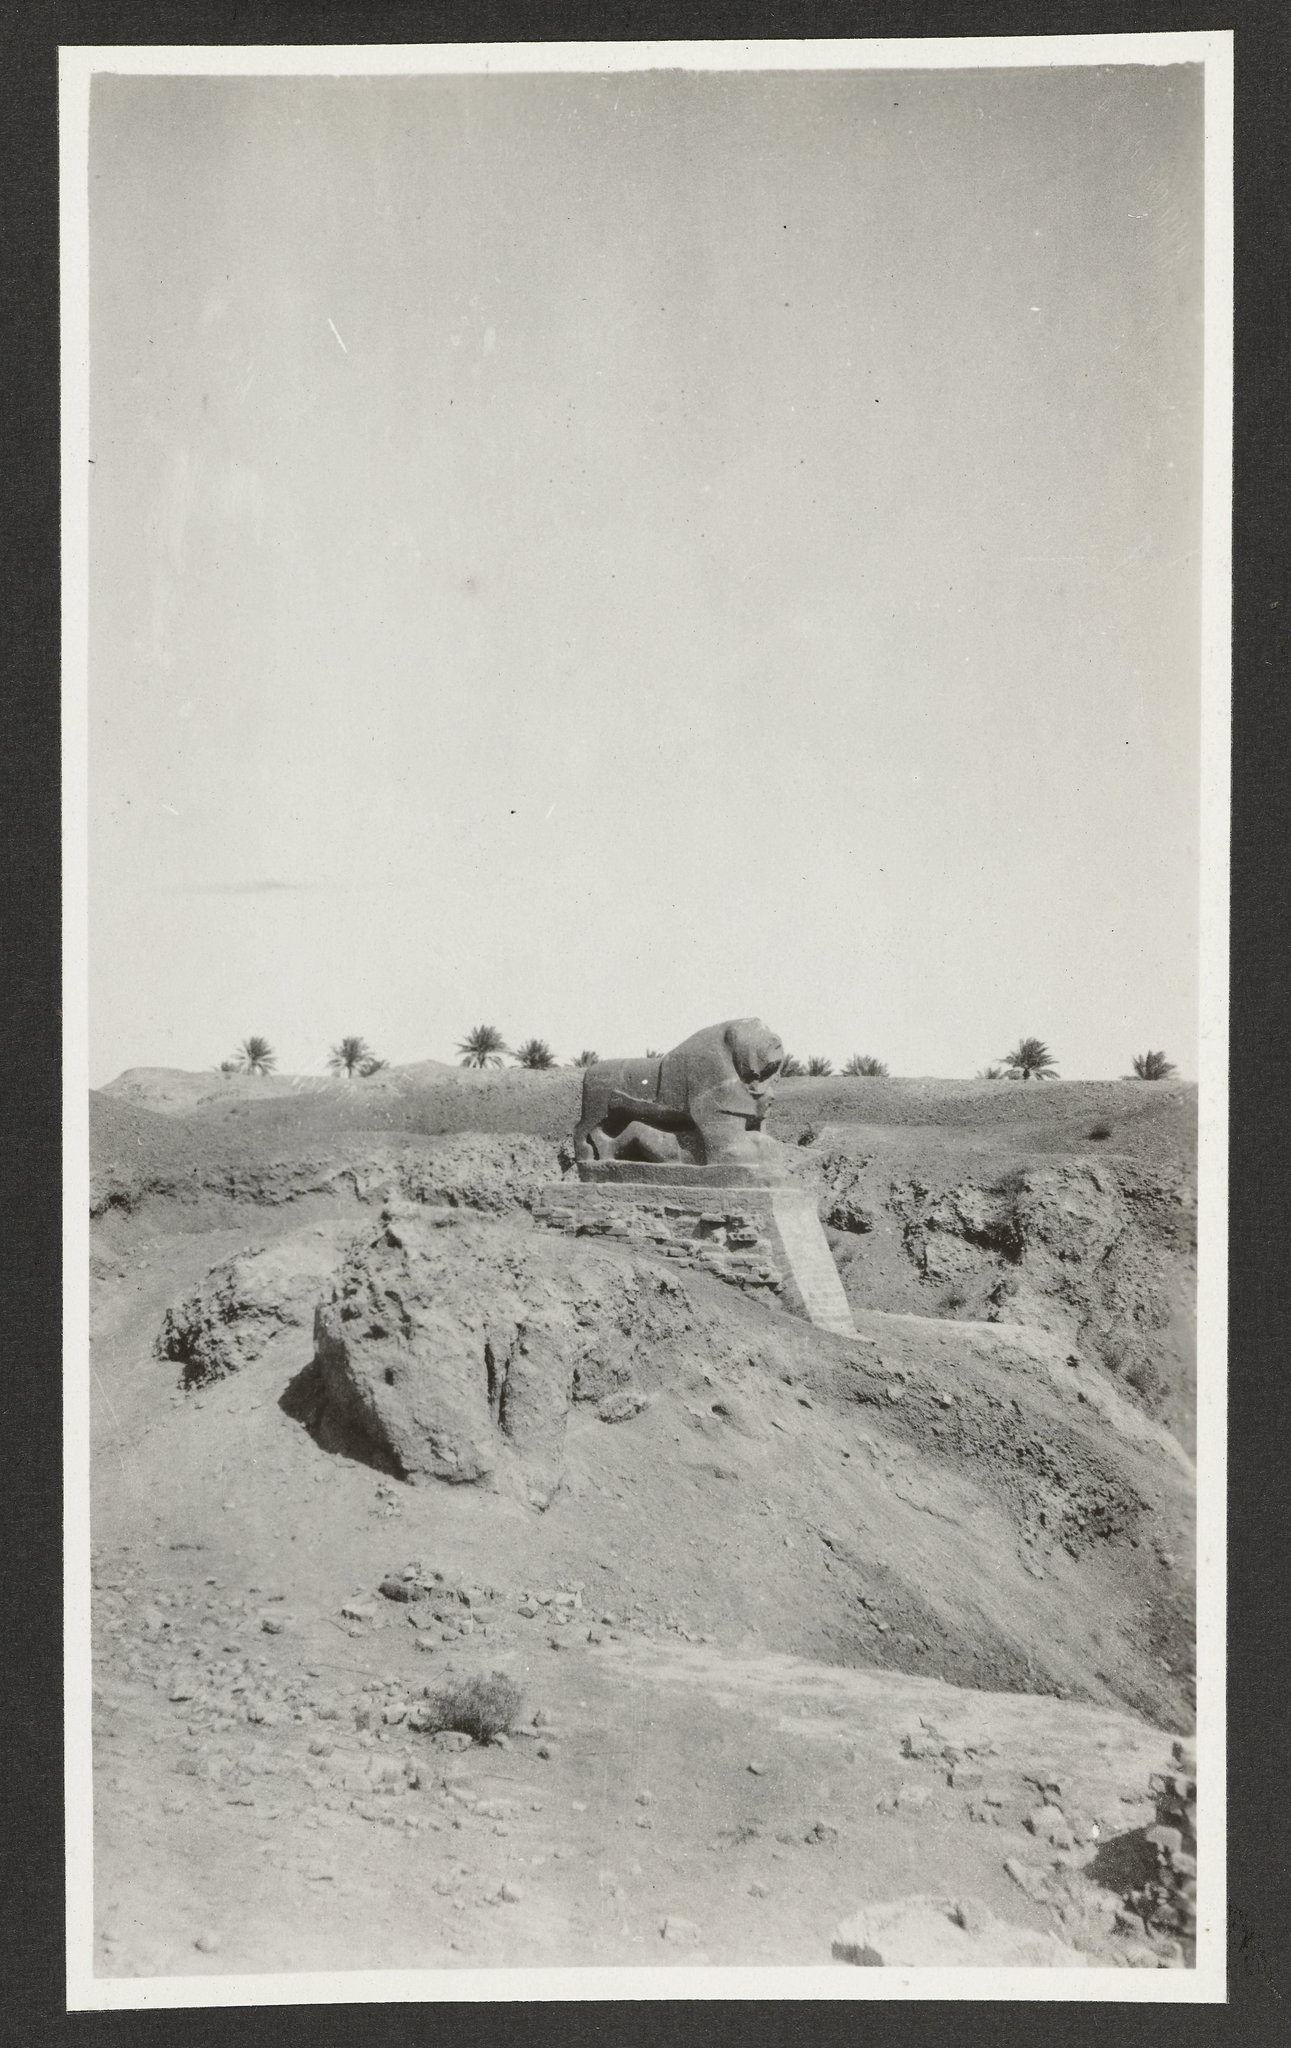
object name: photograph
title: Beeld van leeuw en man van een afstand, te Babylon, Hillah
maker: a.g.a. van eelde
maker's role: engineer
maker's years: 1862-1950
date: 1925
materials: cardboard, paper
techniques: gelatin silver print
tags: irak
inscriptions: number: ‘8.’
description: Titel op object afkomstig uit inventaris (Verklaring der Photo's) behorend bij het album.